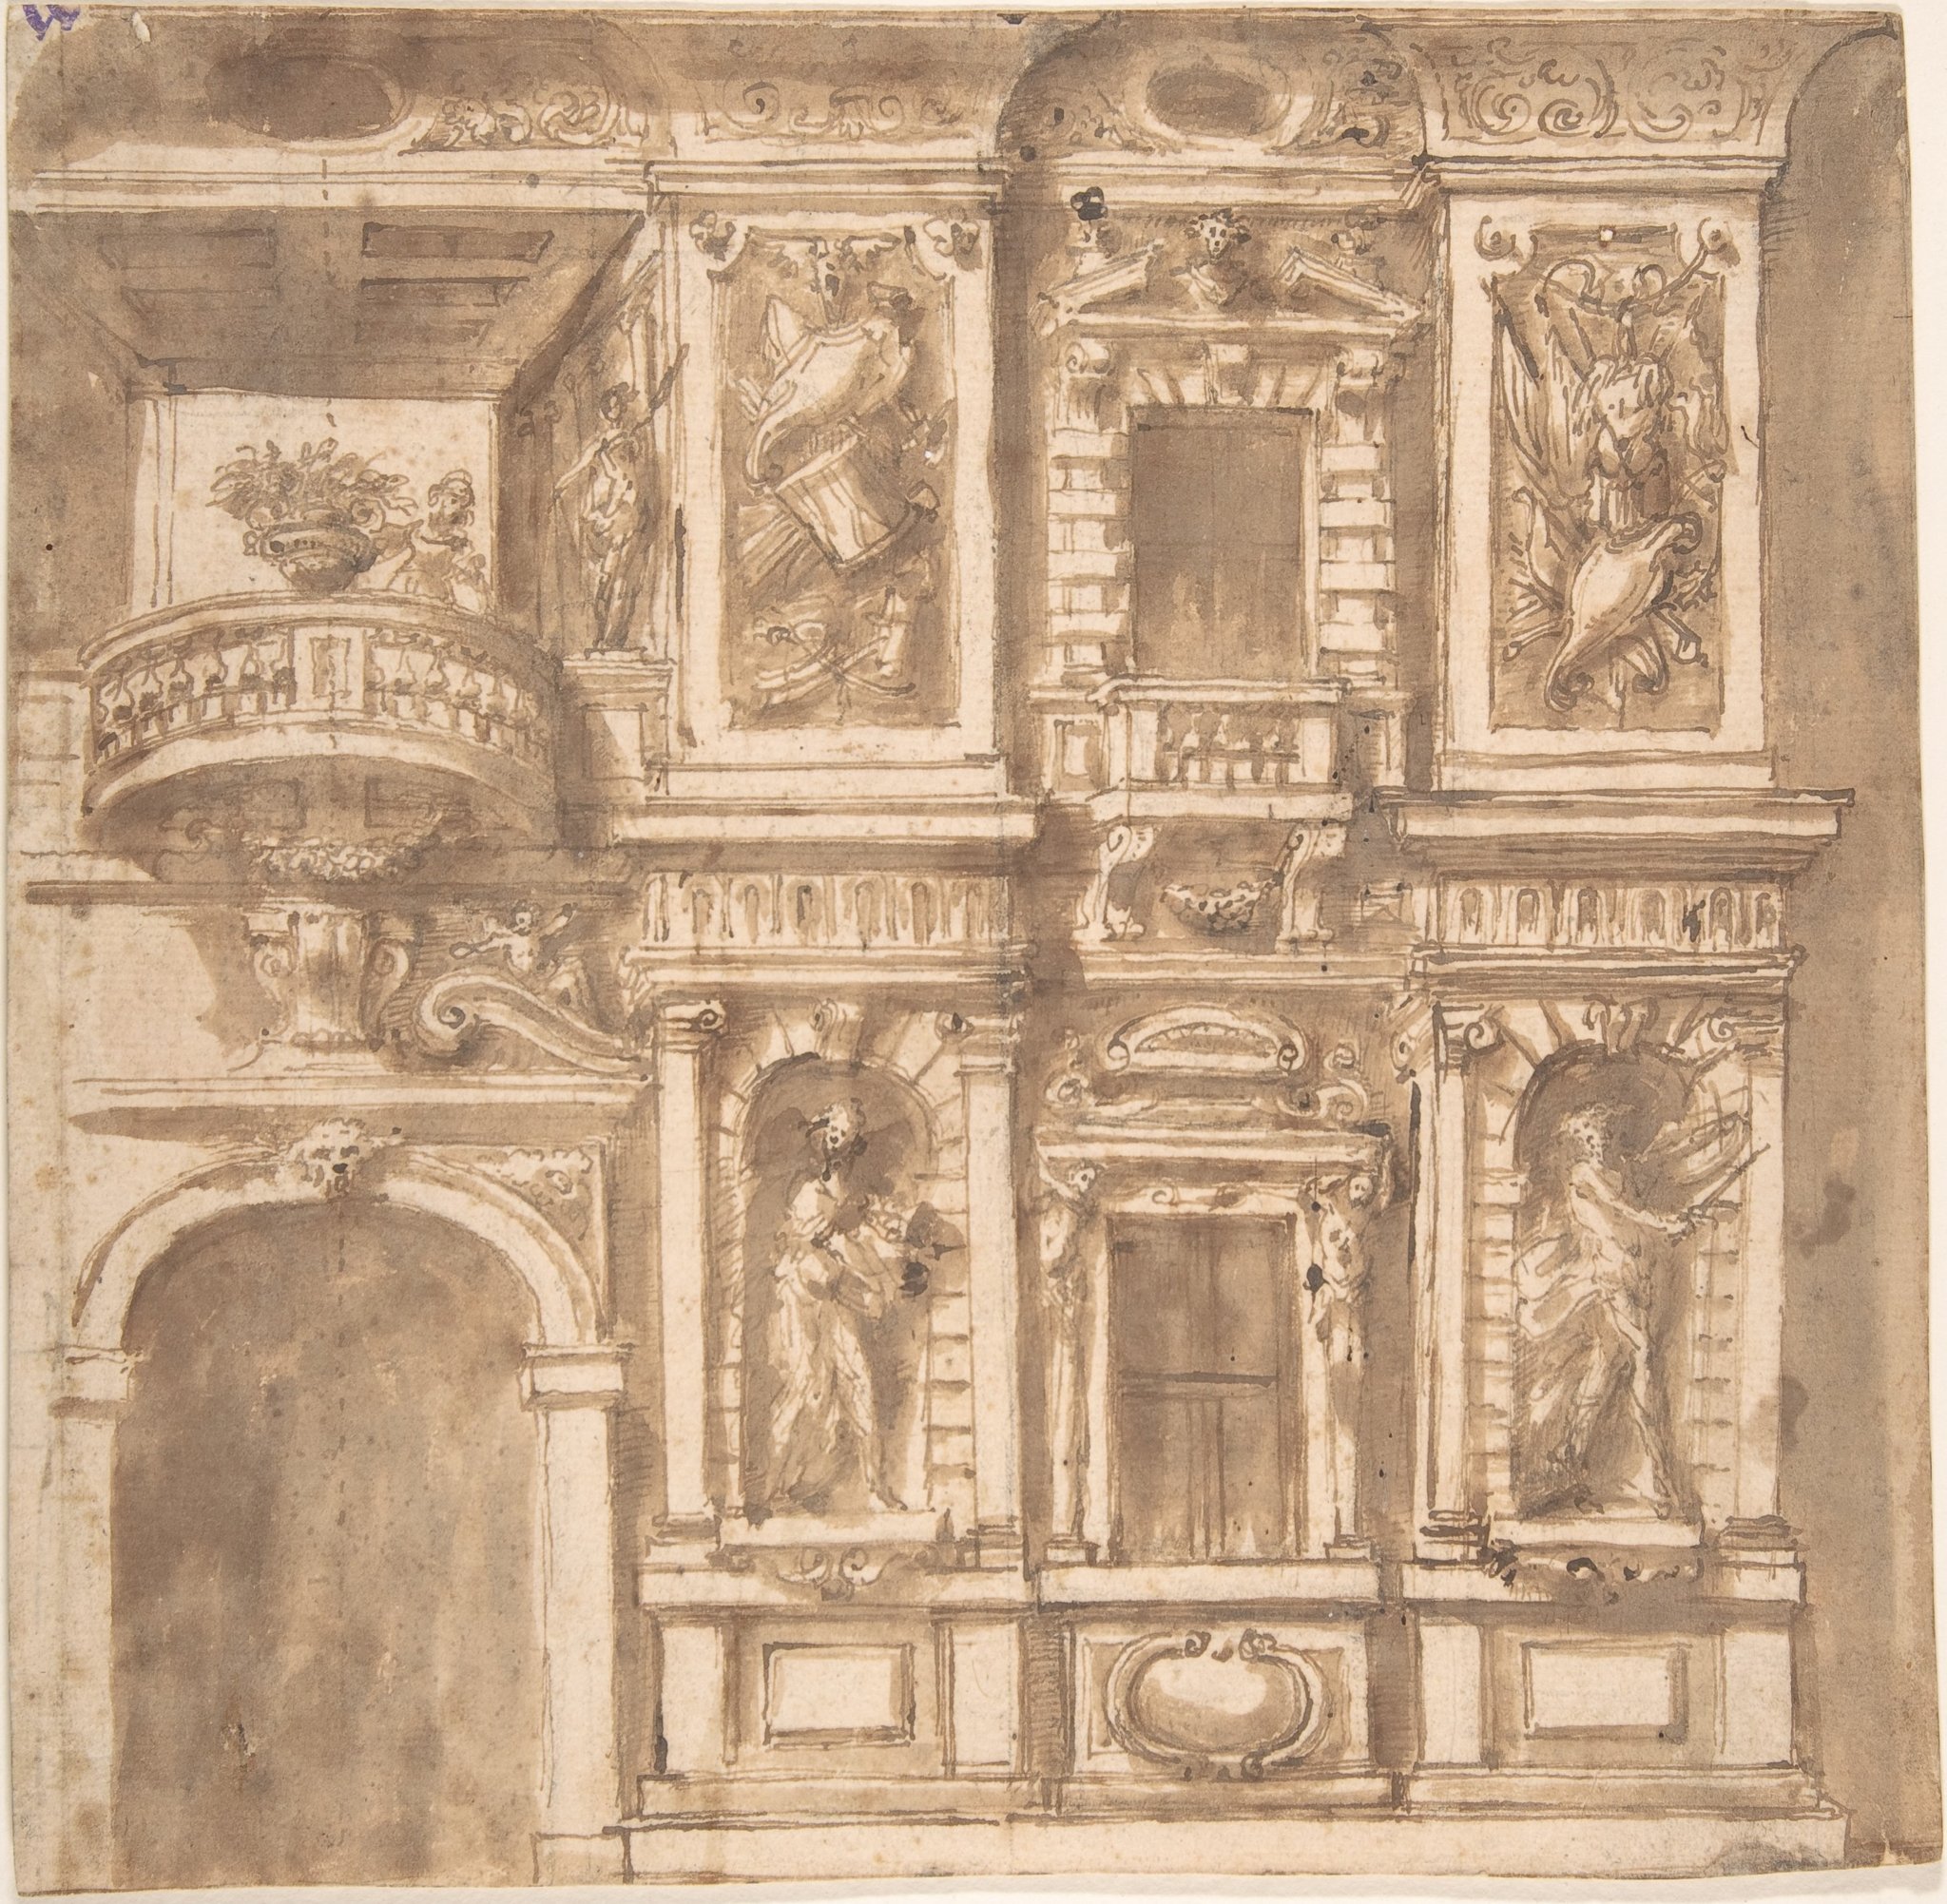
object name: drawing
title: Design for a Façade with Statues in Niches and Armorial Trophies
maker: anonymous, italian, 17th century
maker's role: artist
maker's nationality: italian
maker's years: 1600-1700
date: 1601-1700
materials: graphite, ink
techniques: brush, pen, wash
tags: architecture